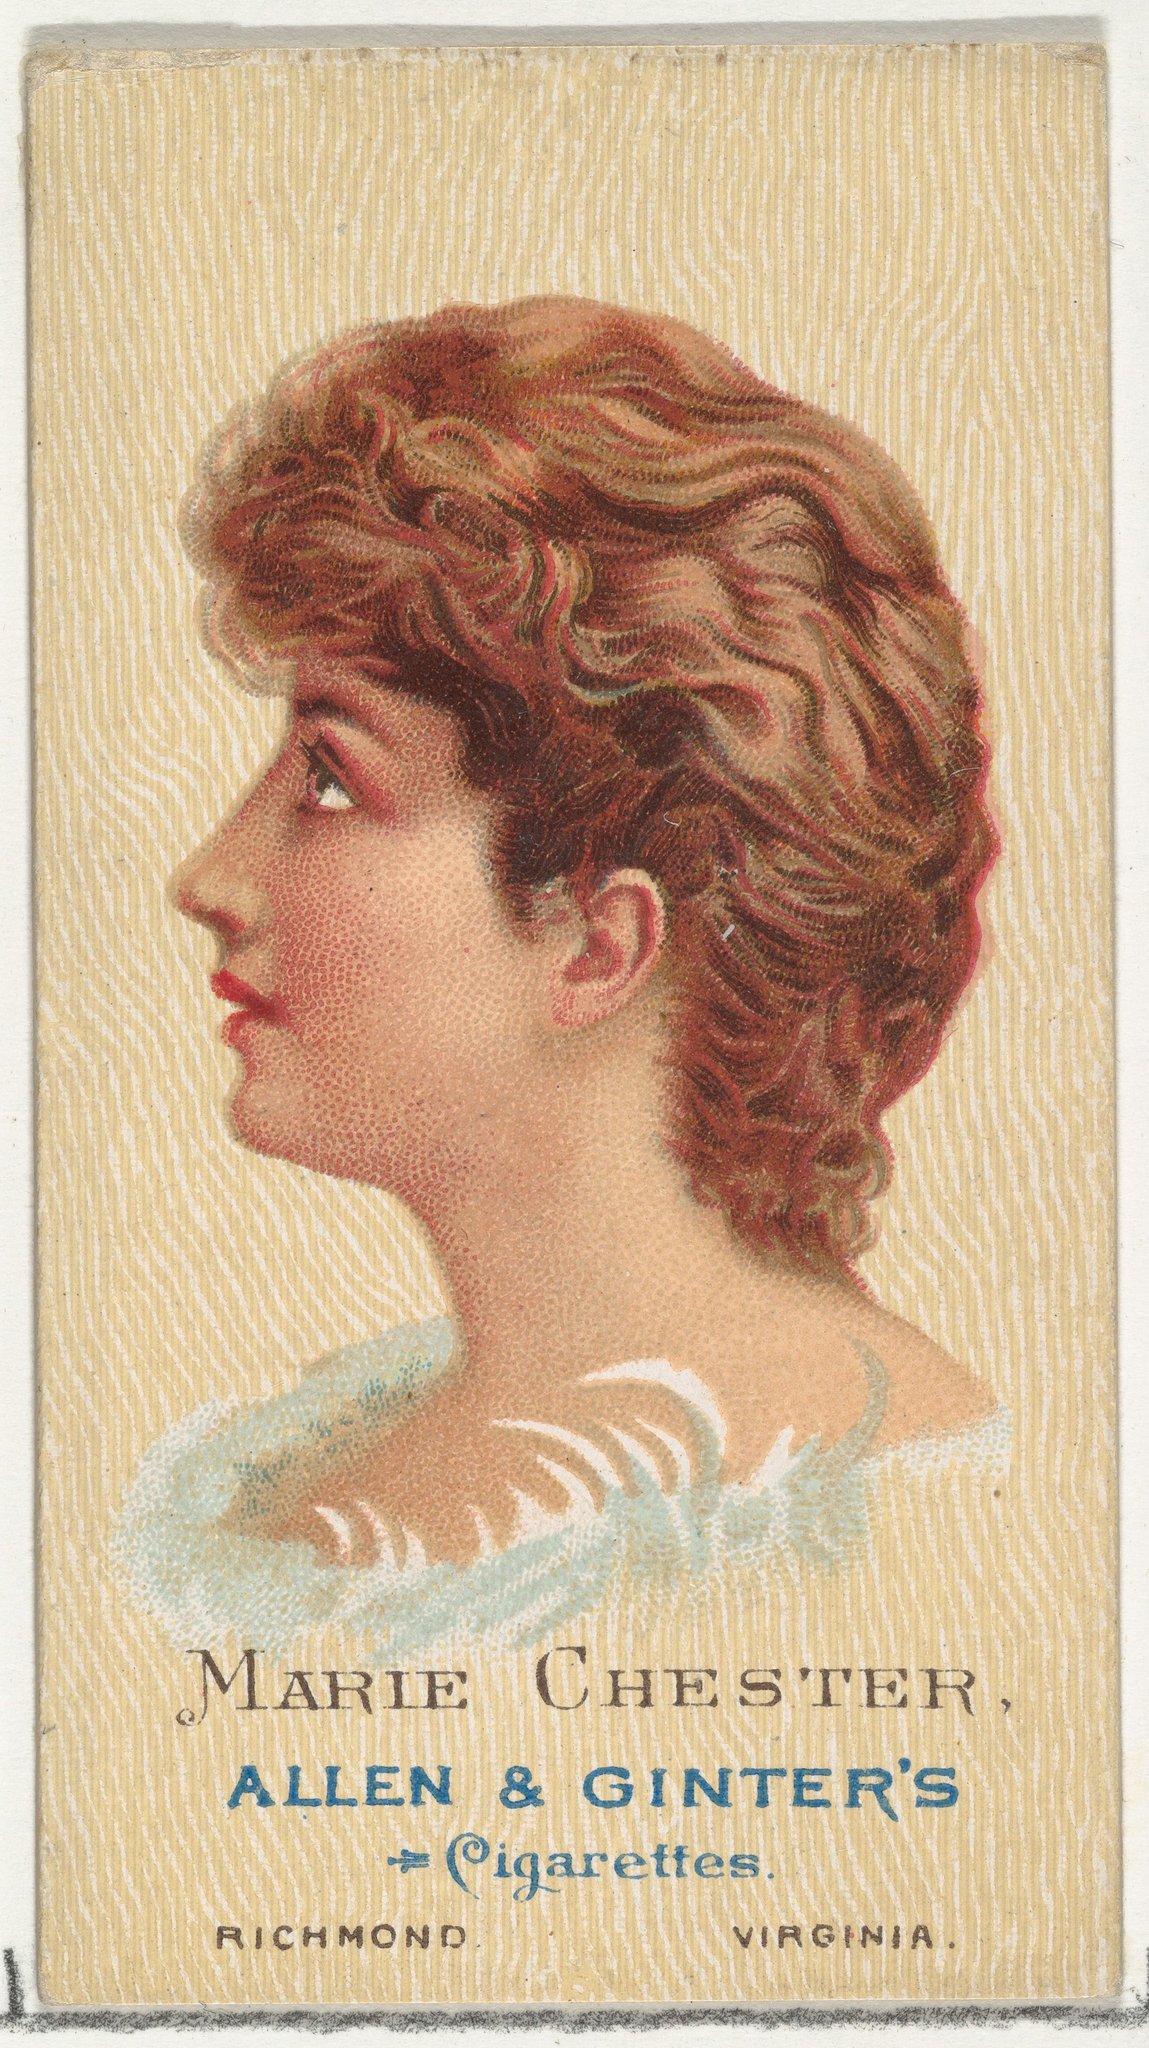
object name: print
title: Marie Chester, from World's Beauties, Series 2 (N27) for Allen & Ginter Cigarettes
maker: allen & ginter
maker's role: publisher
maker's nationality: american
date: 1888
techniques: color lithograph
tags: women